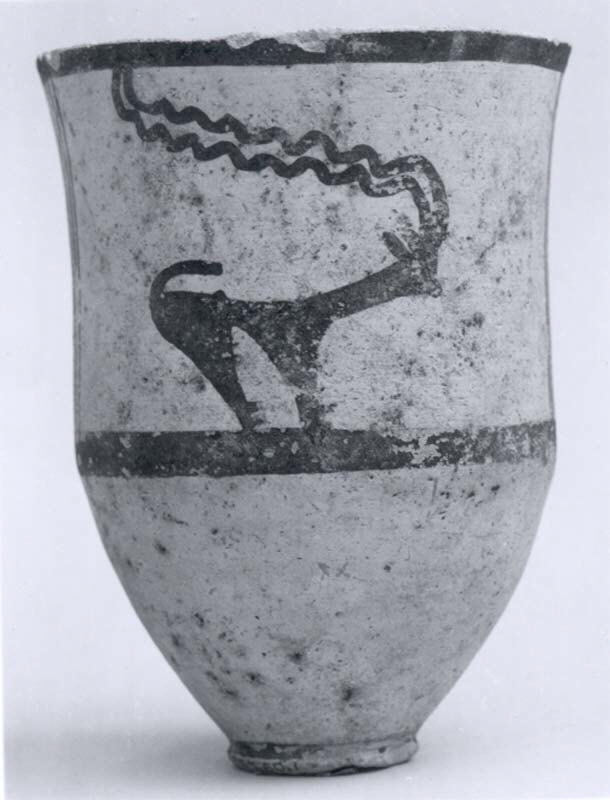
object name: cup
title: Cup decorated with horned animals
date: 4000-3600 BCE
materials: ceramic, paint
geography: central iran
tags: animals